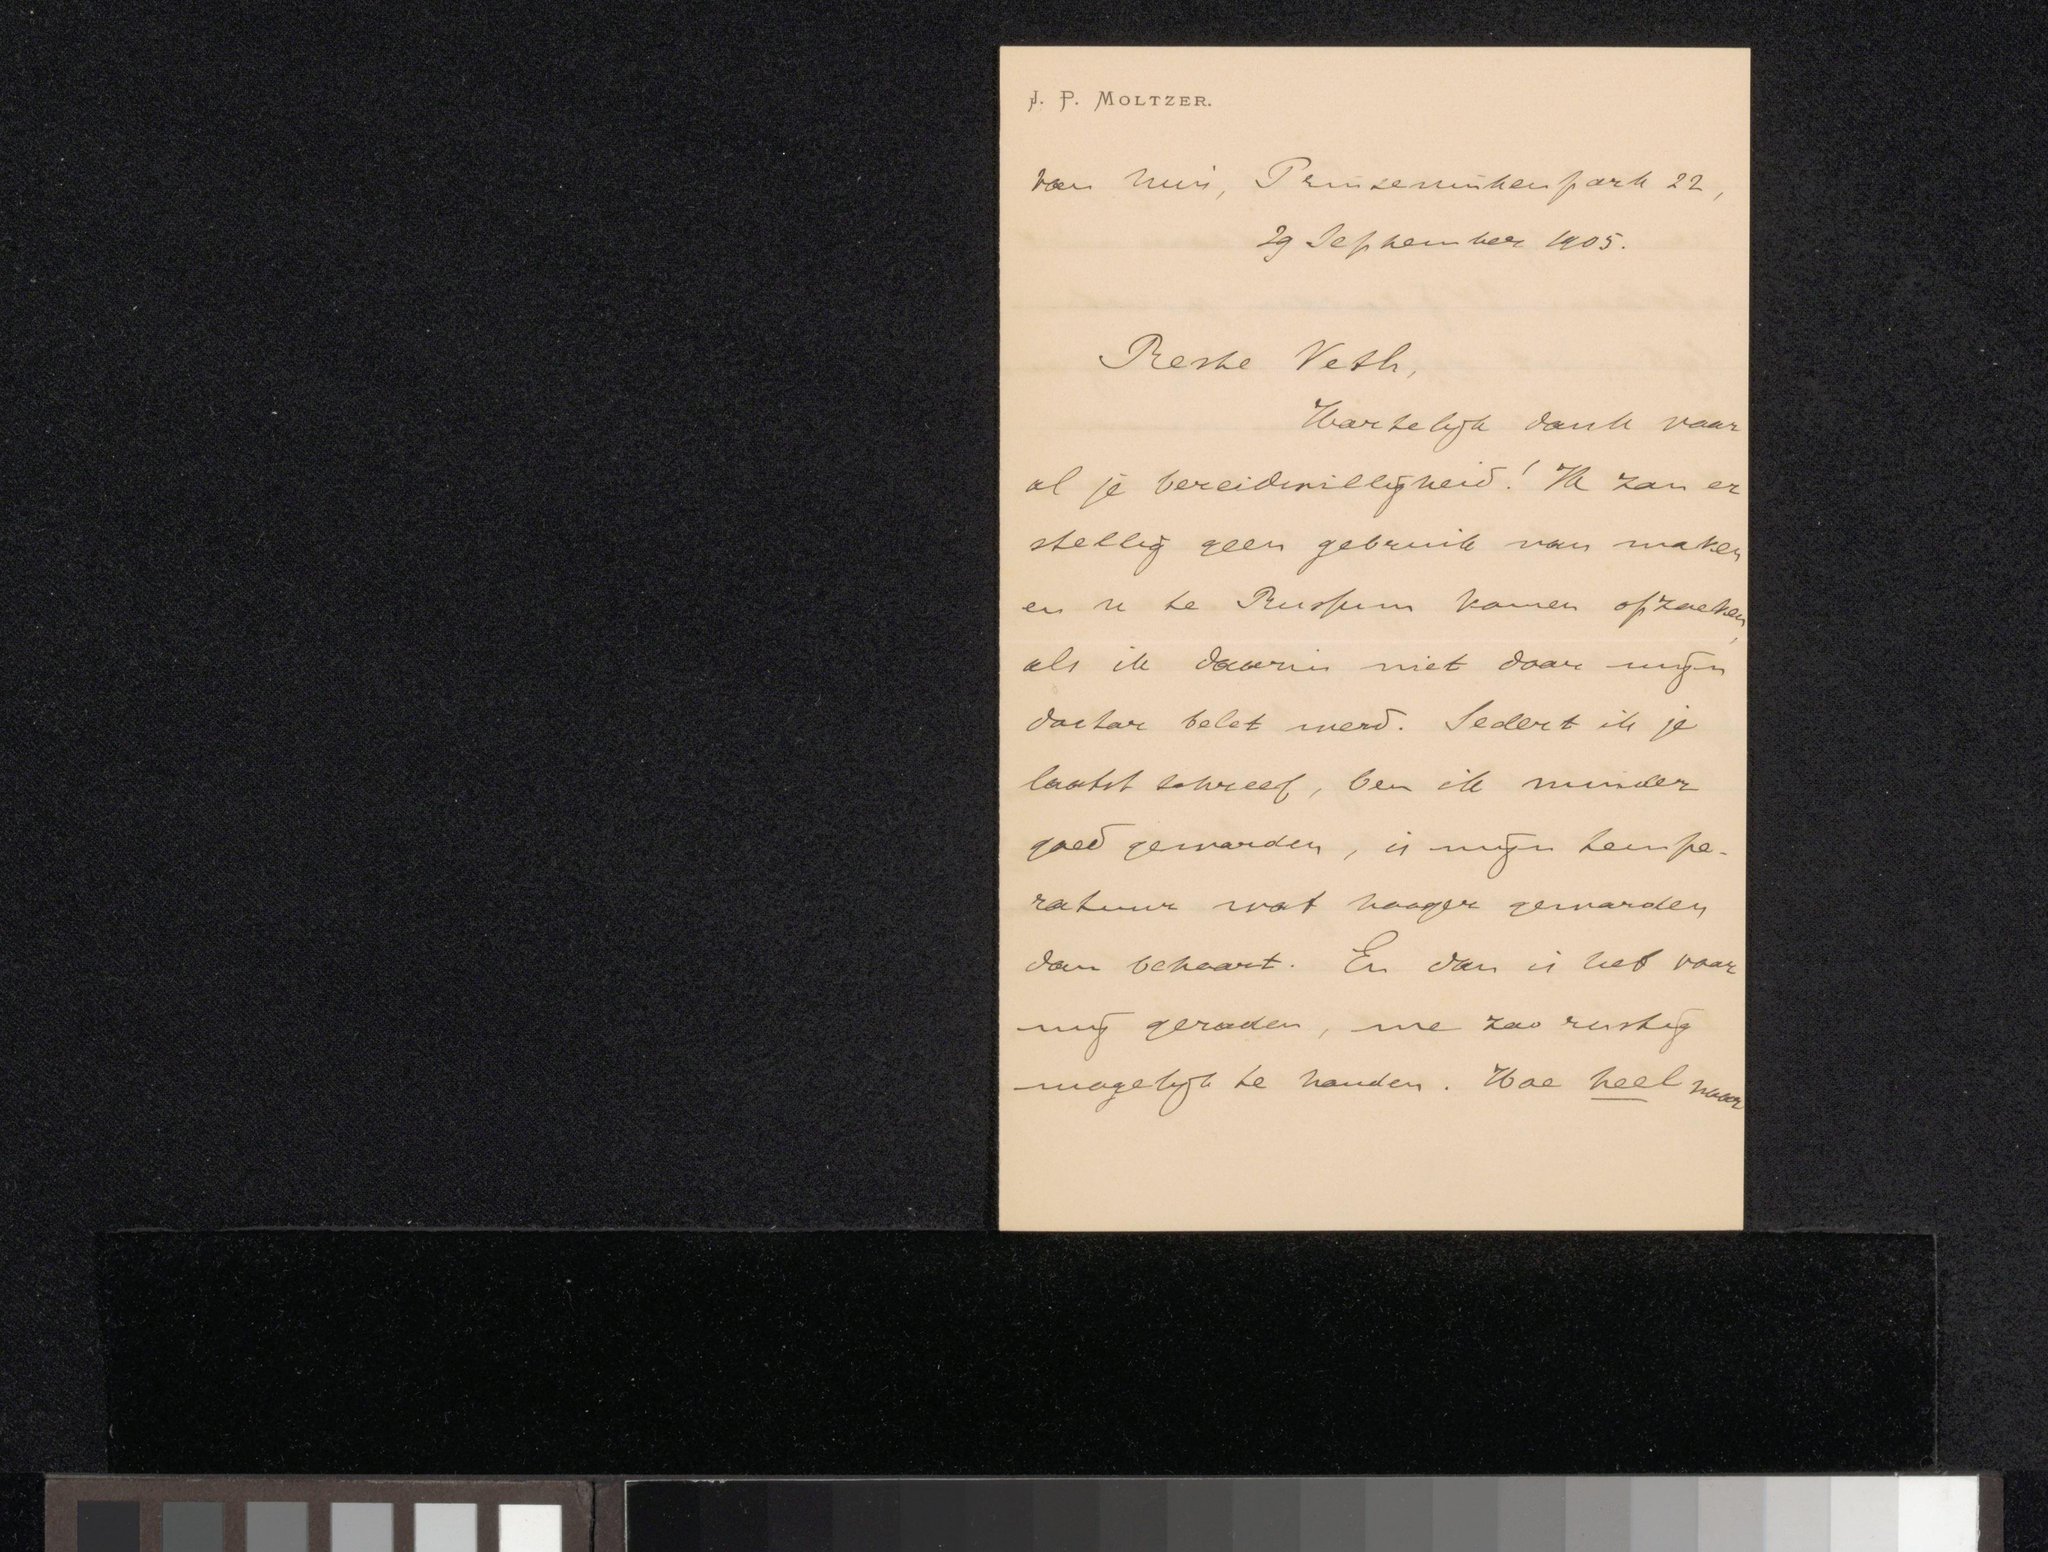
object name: letter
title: Brief aan Jan Veth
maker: jacob pieter moltzer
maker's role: jurist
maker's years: 1850-1907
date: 1905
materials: ink, paper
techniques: pen, writing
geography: the hague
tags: dordrecht, amsterdam, painter, print maker, draughtsman, designer, jan veth, utrecht, wilhelmus johannes steenhoff, diseases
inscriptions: collector's mark: ‘RPK’, name: ‘J.P.MOLTZER.’, watermark